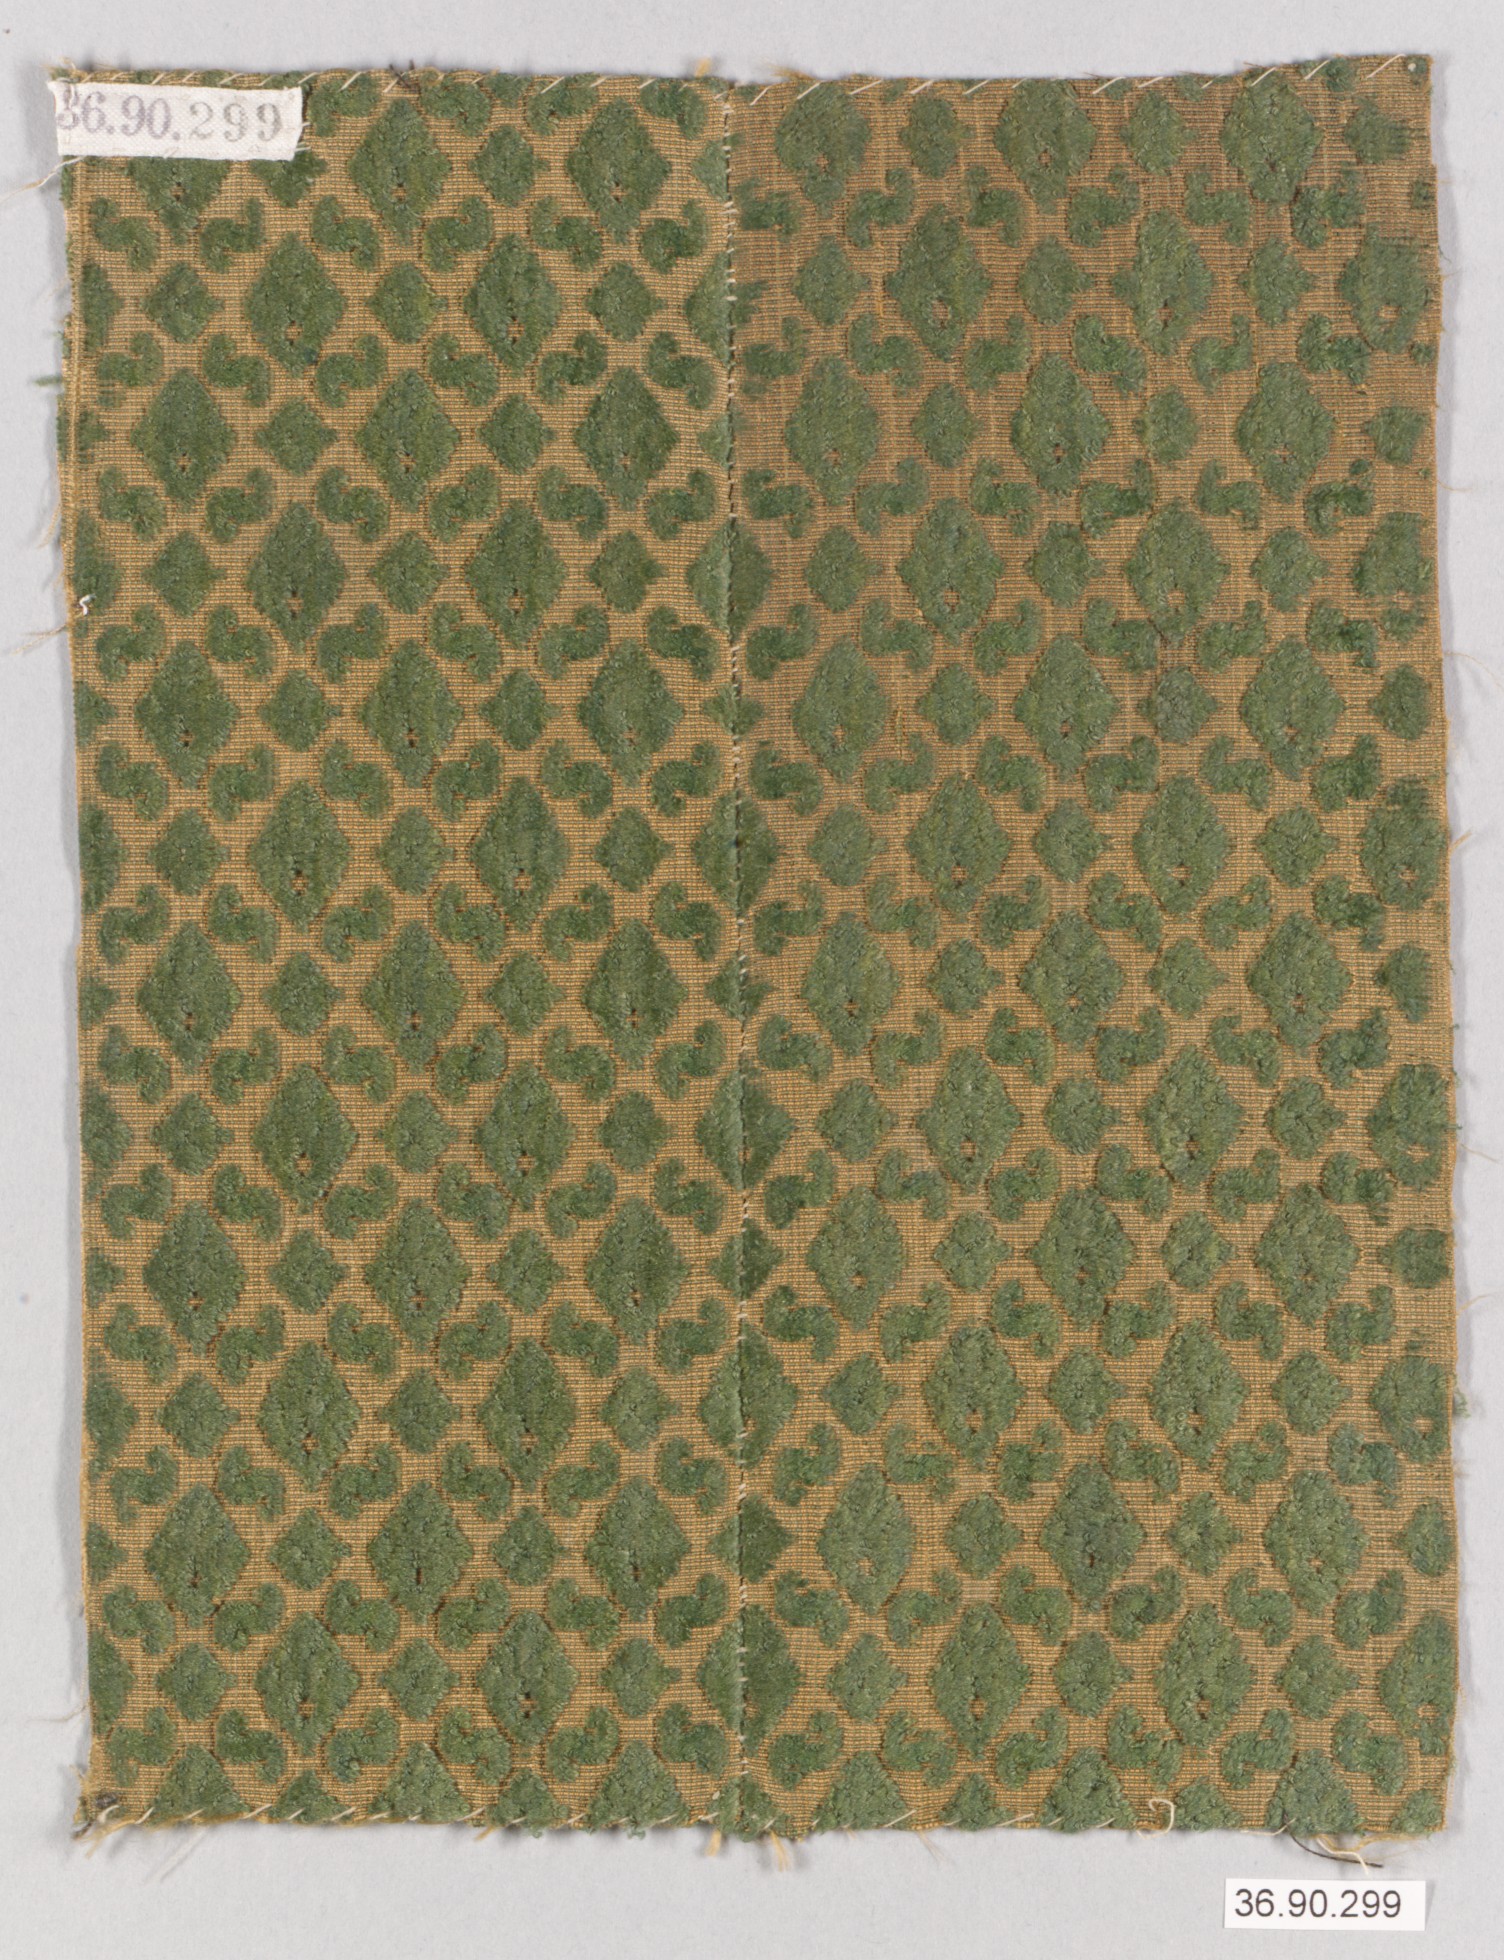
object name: piece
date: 1501-1700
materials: silk